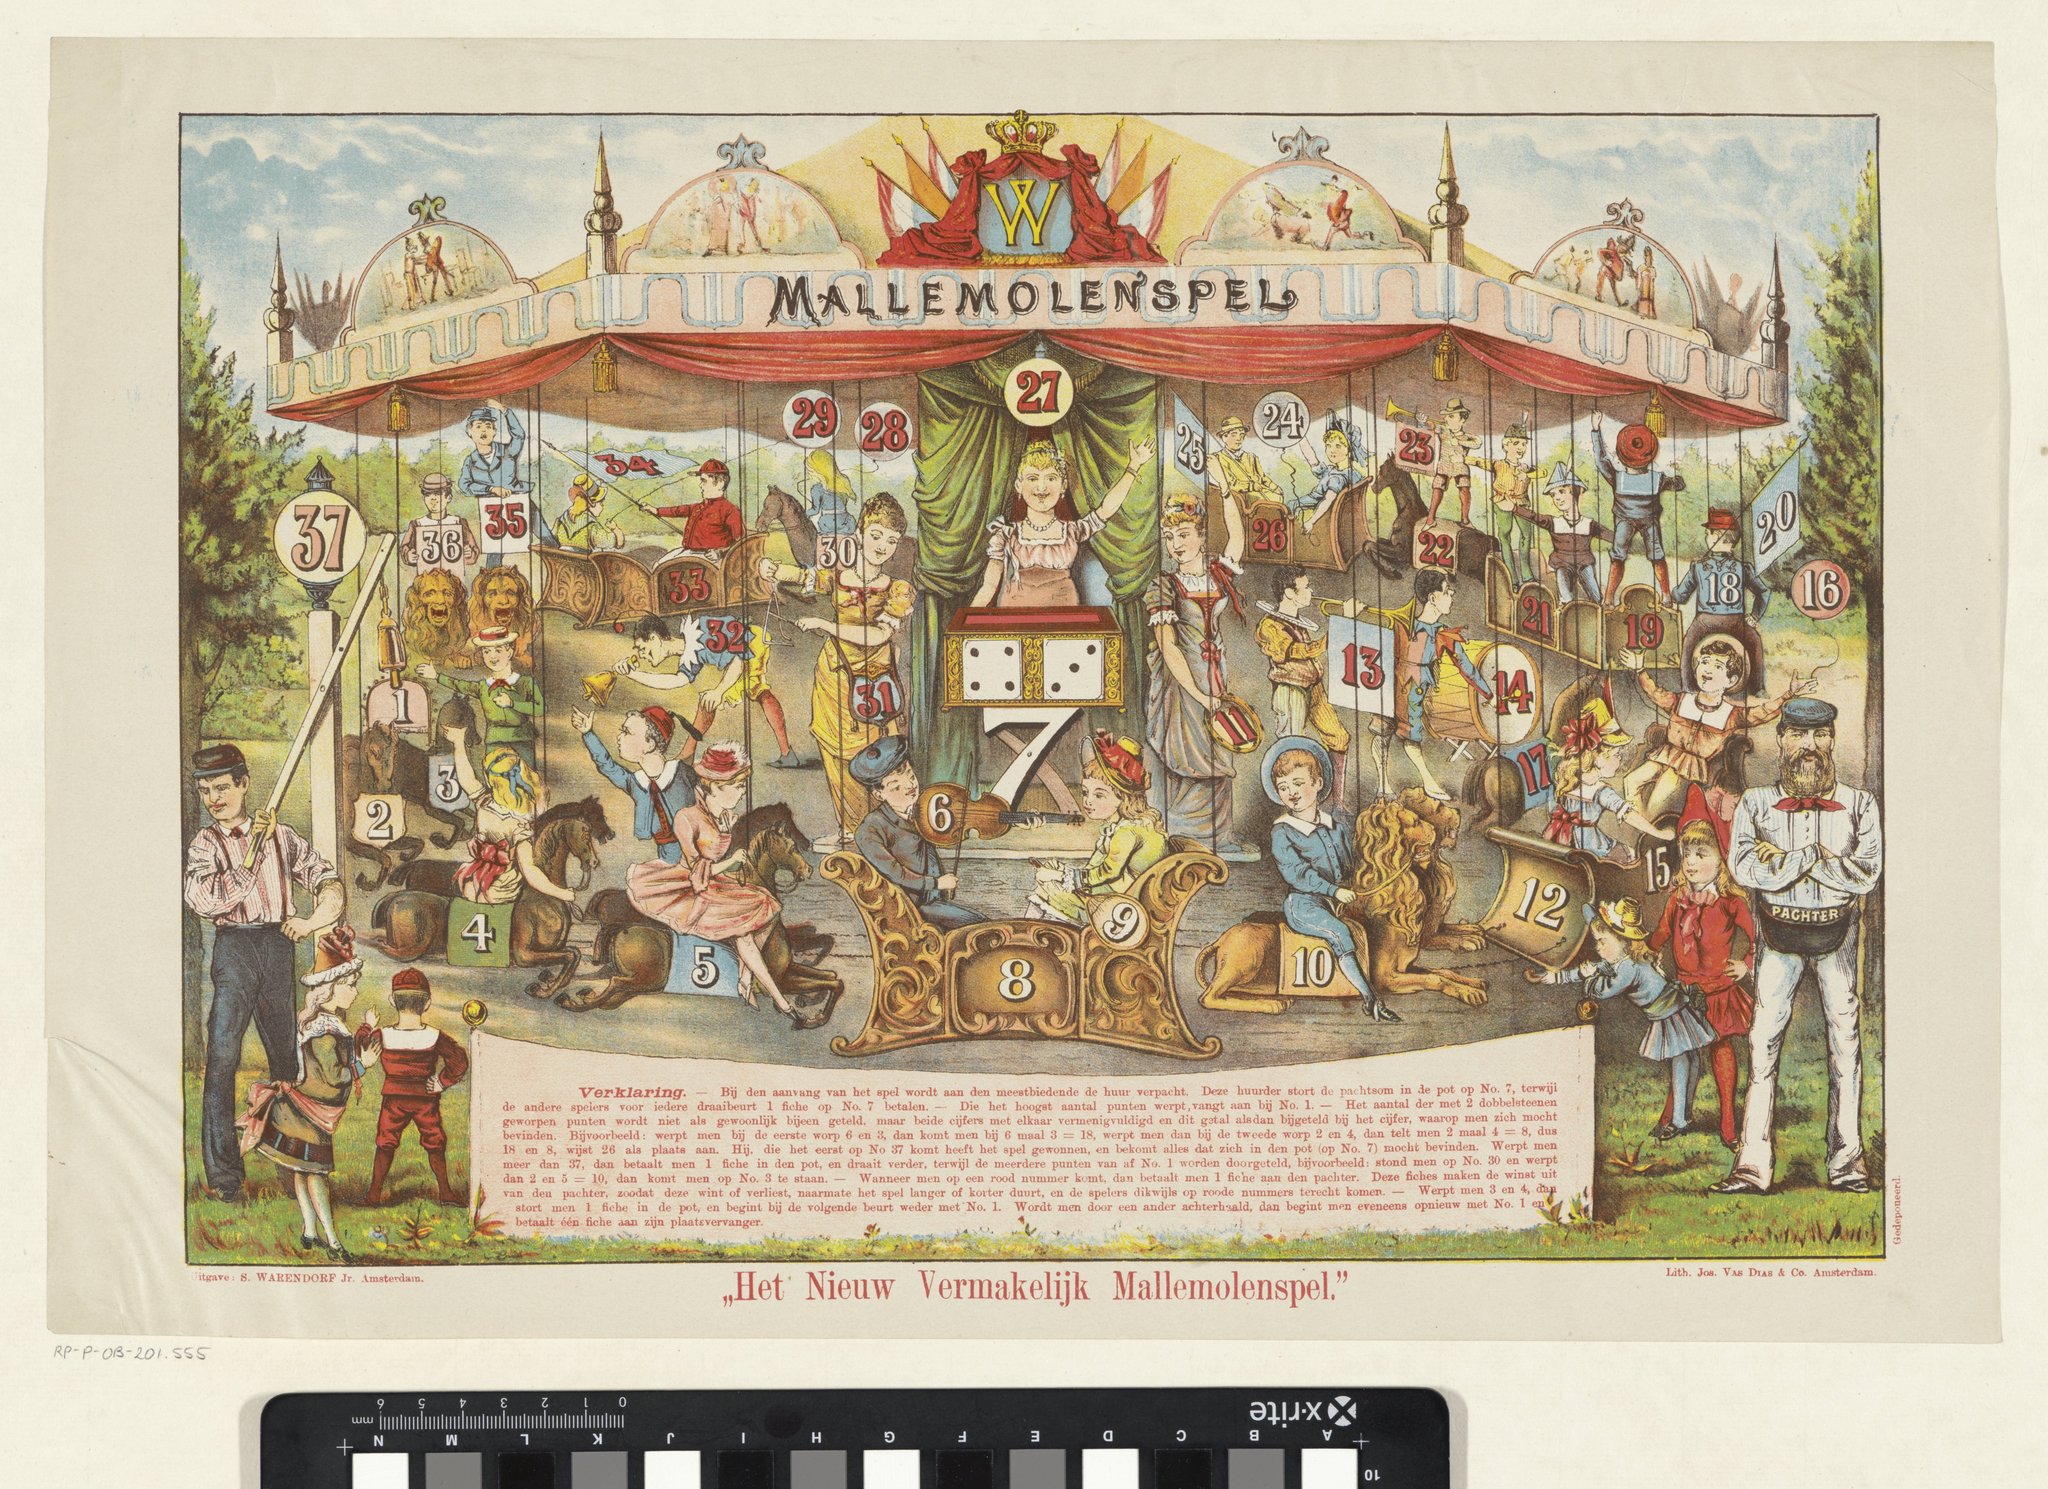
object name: popular print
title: "Het nieuw vermakelijk mallemolenspel."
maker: s. warendorf (ii)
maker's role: publisher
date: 1887-1891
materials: paper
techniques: lithograph, letterpress printing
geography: amsterdam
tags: merry-go-round, roundabout; chair o'plane, board-games of chance, board-games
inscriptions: collector's mark: Lugt 2760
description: Bordspel met een carroussel met kinderen met in het midden groot het cijfer 7. Daaromheen op de carroussel de cijfers 1-37. Midden boven de titel op de carroussel. Midden onder de spelregels in boekdruk.